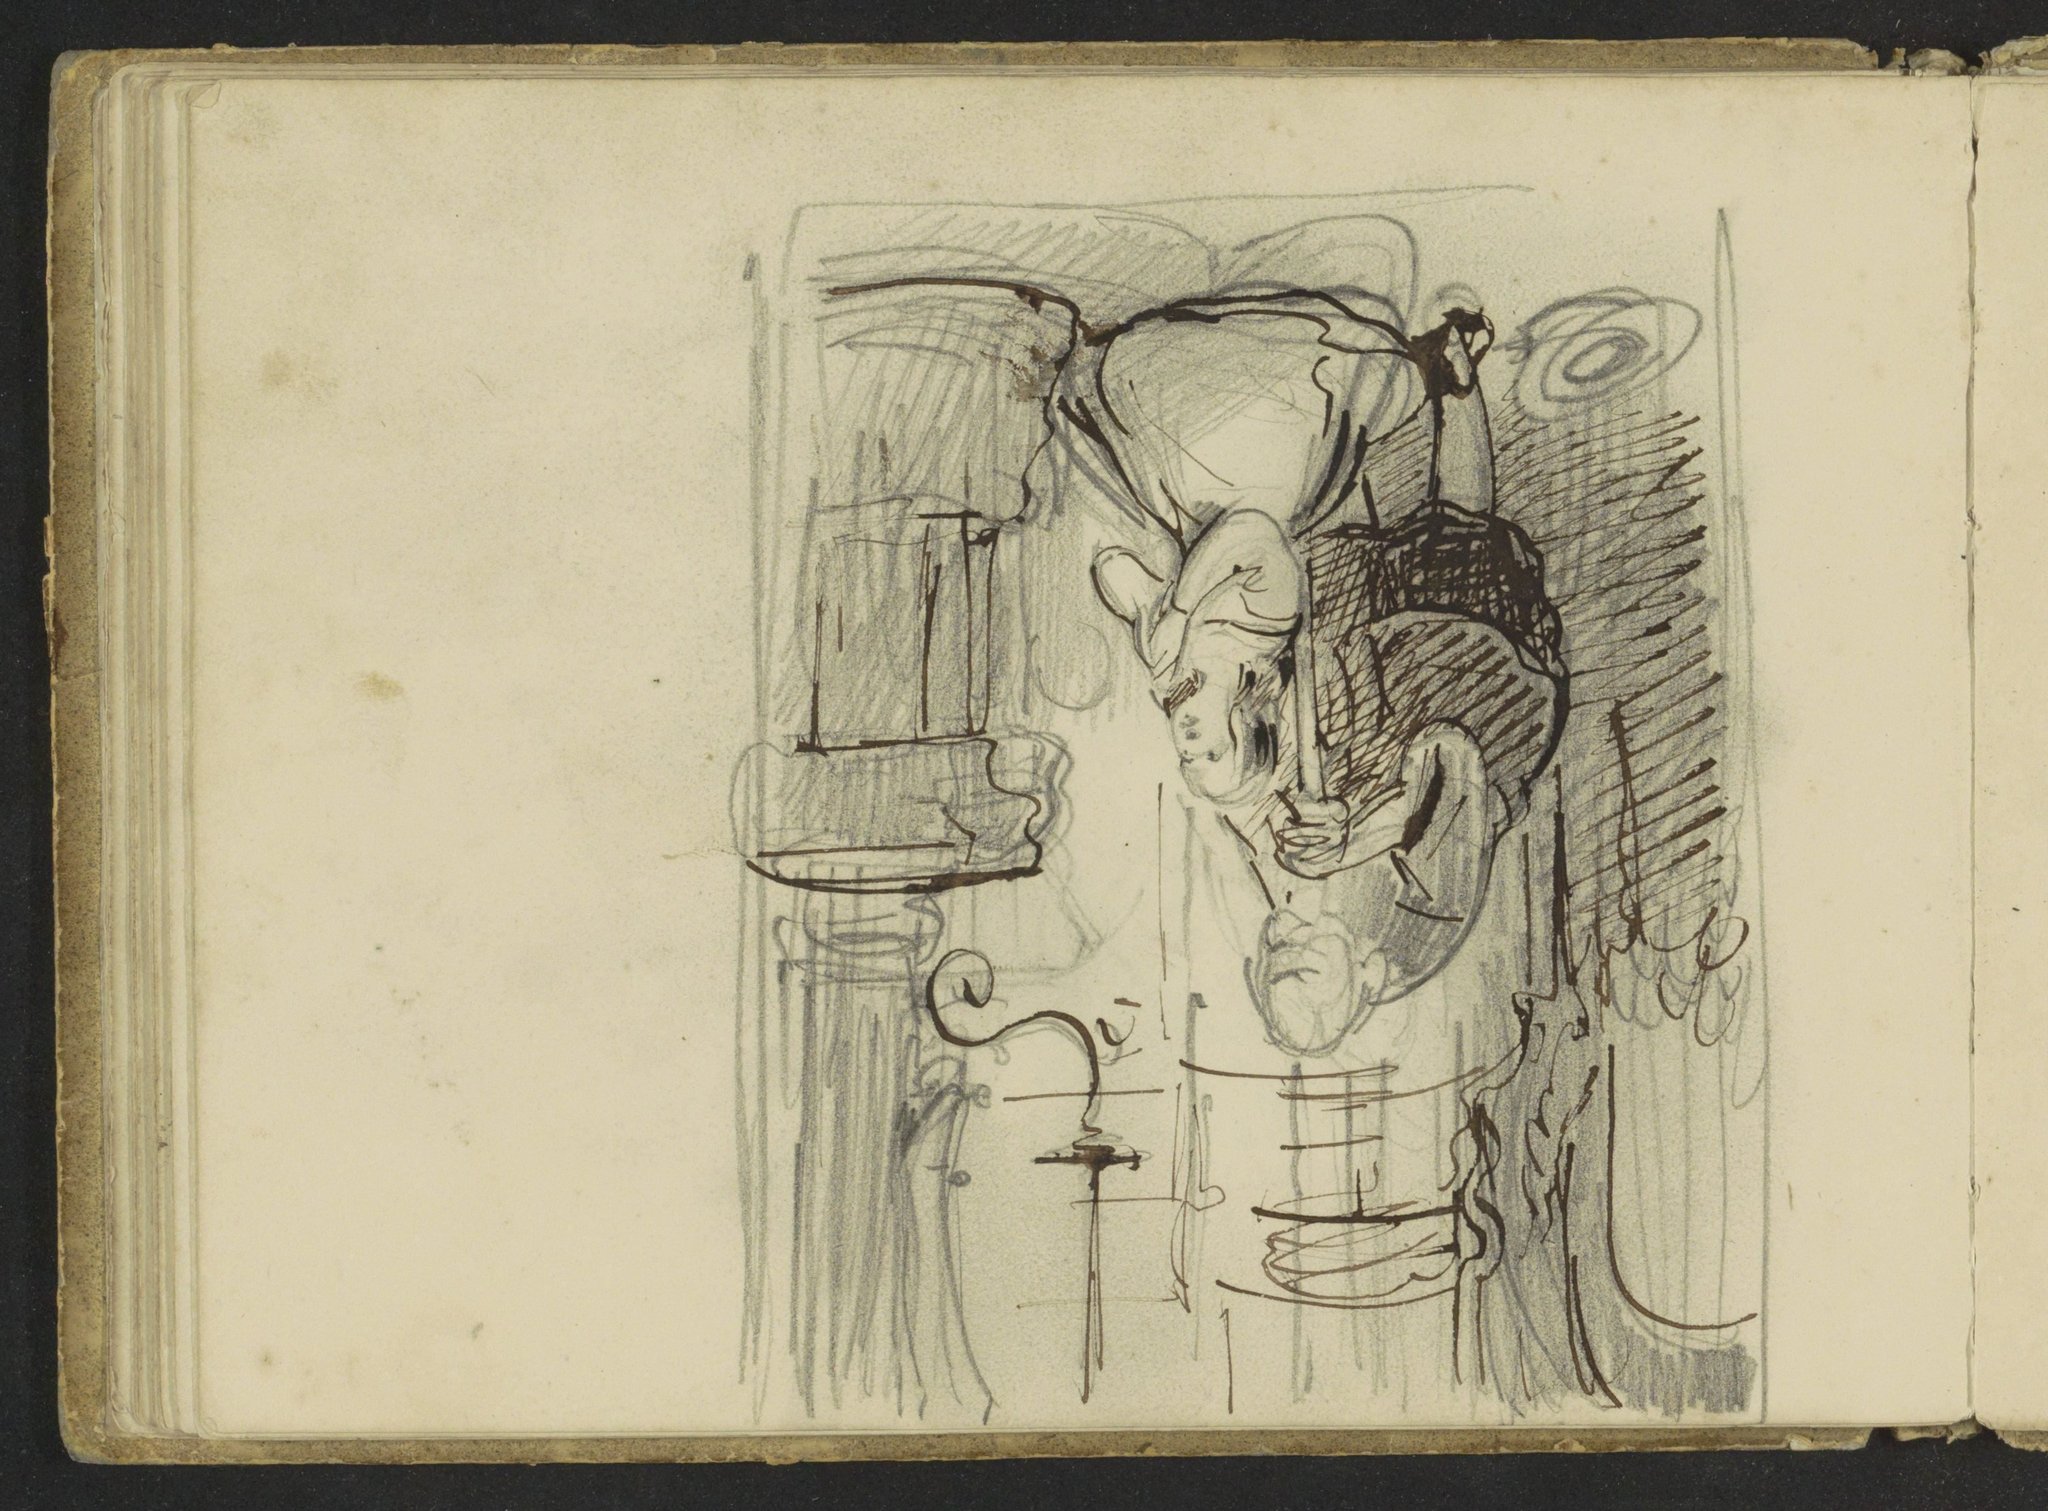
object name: sketchbook leaf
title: Man en biddend meisje in een interieur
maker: willem hendrik schmidt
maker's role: draughtsman, painter, print maker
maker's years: 1809-1849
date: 1819-1849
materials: ink, paper, pencil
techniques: pen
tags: interior of the house, one person praying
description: Tekening in een kader. Blad 24 verso uit een schetsboek met 36 bladen.